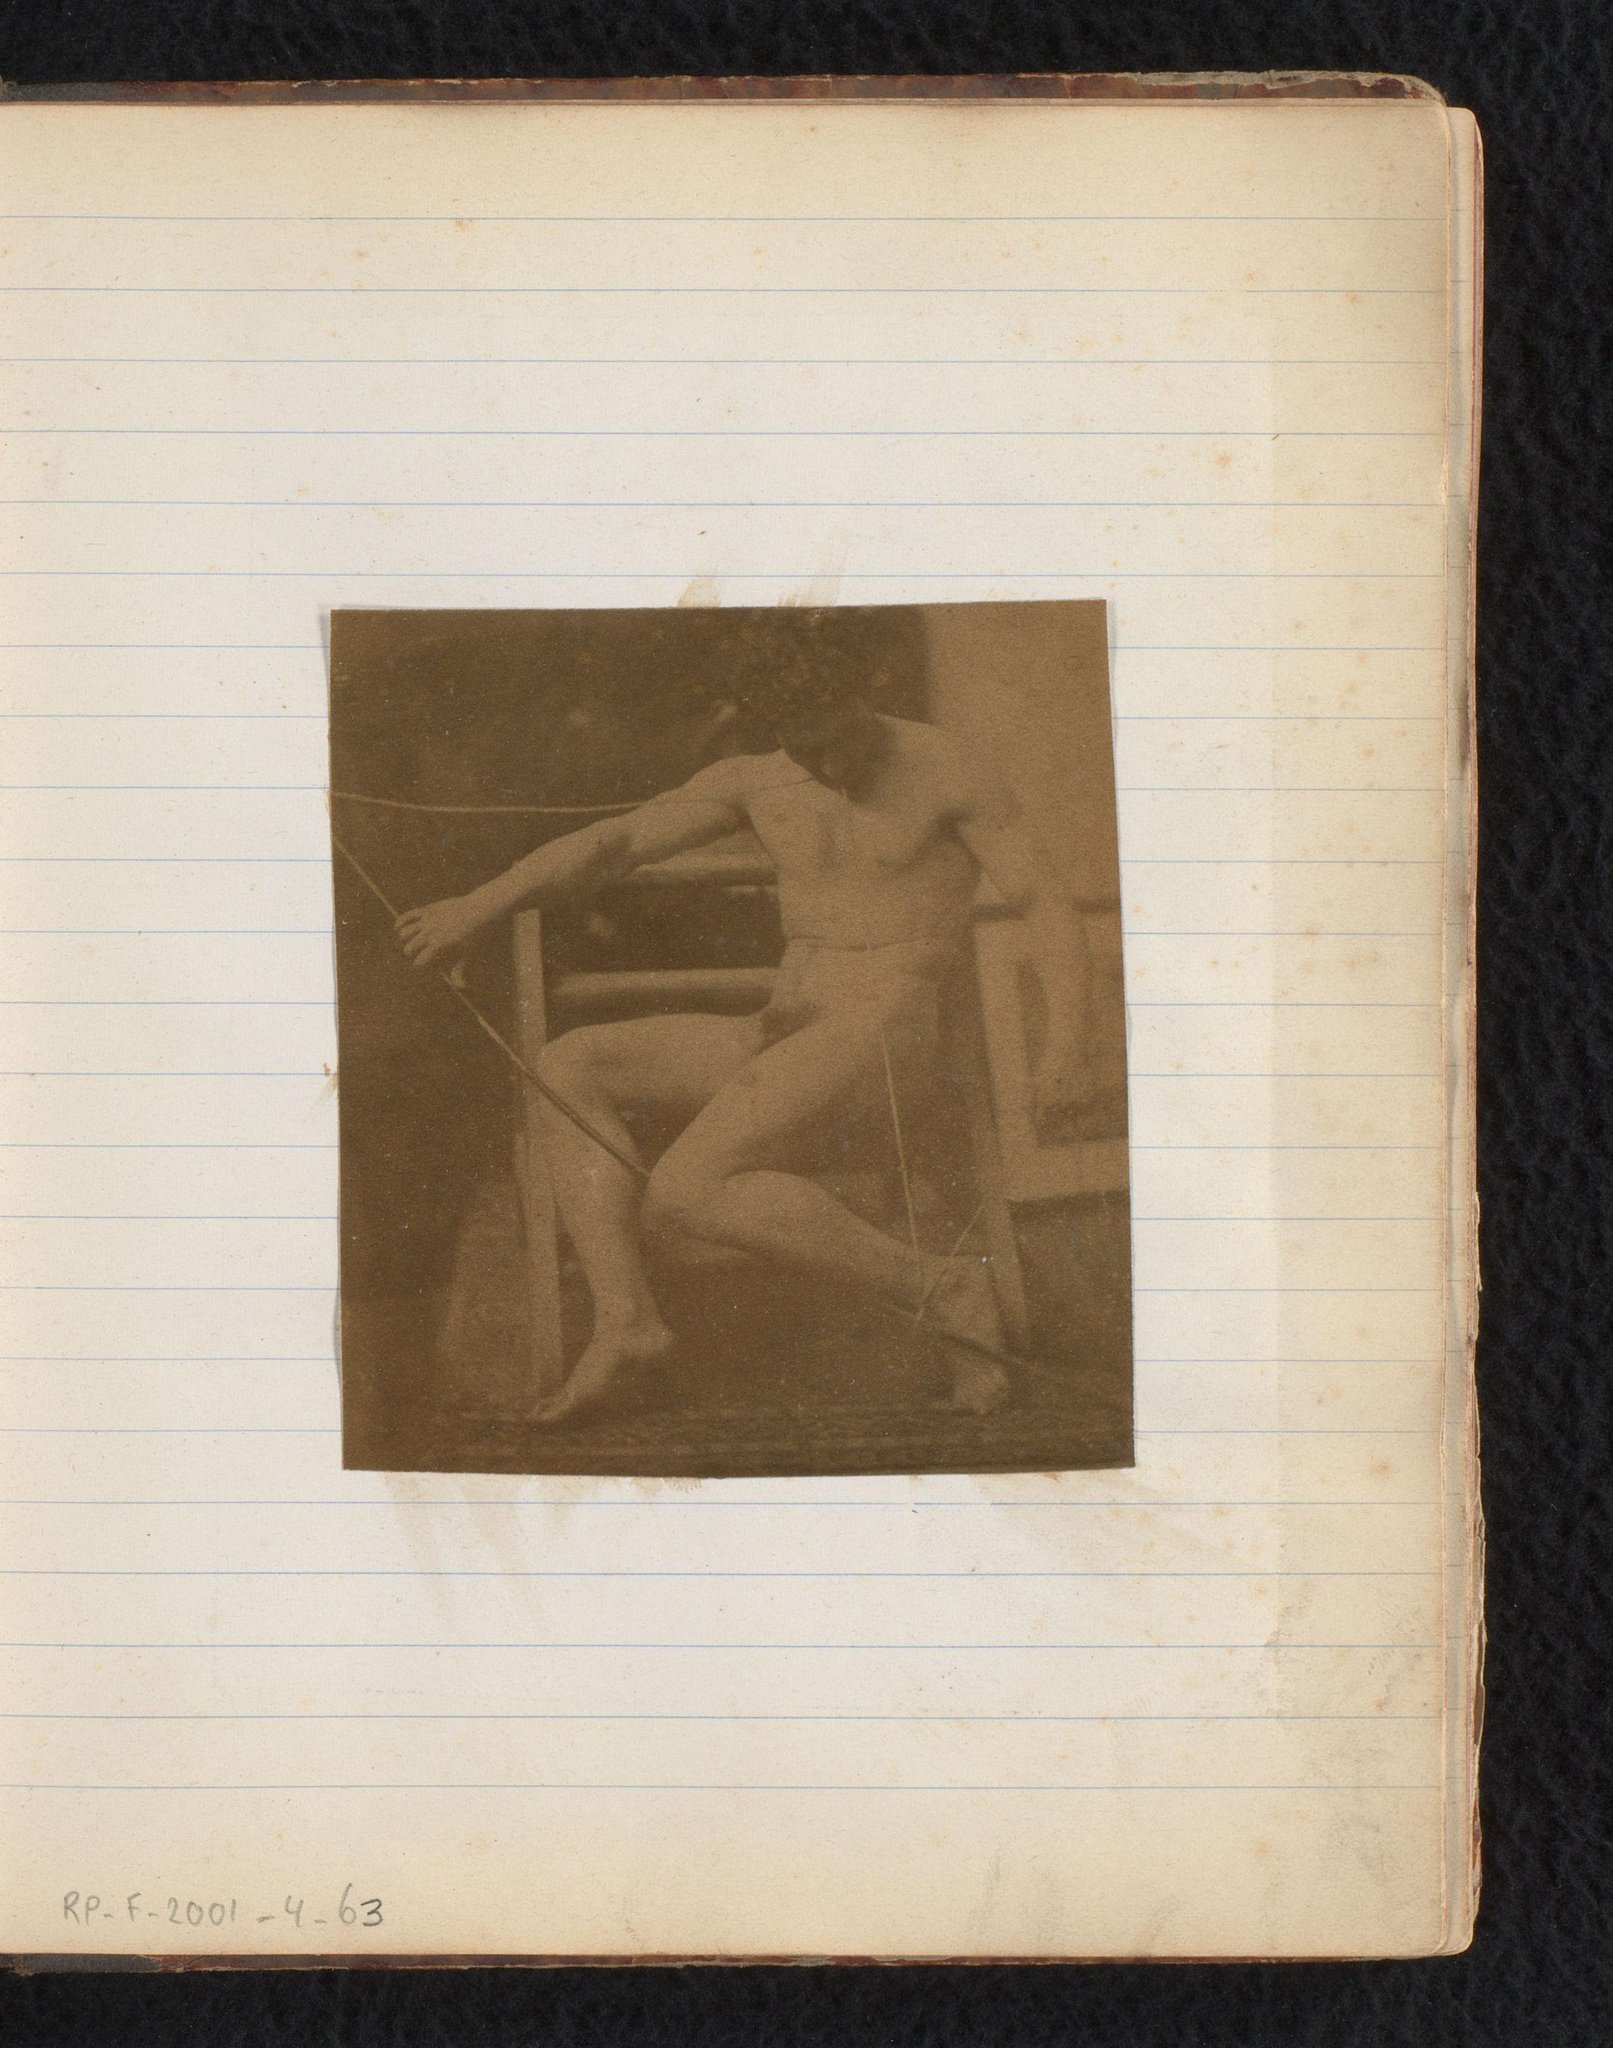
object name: album leaf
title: Studie van een mannelijk naaktmodel, zittend op een trapje, van voren gezien met touw en boog op schoot, in het atelier van Jacques de Lalaing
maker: jacques lalaing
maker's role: painter, sculptor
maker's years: 1858-1917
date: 1883-1914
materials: photographic support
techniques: albumen print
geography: brussels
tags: archer's weapons: bow and arrow, adult man, artist (in general) working from nude model